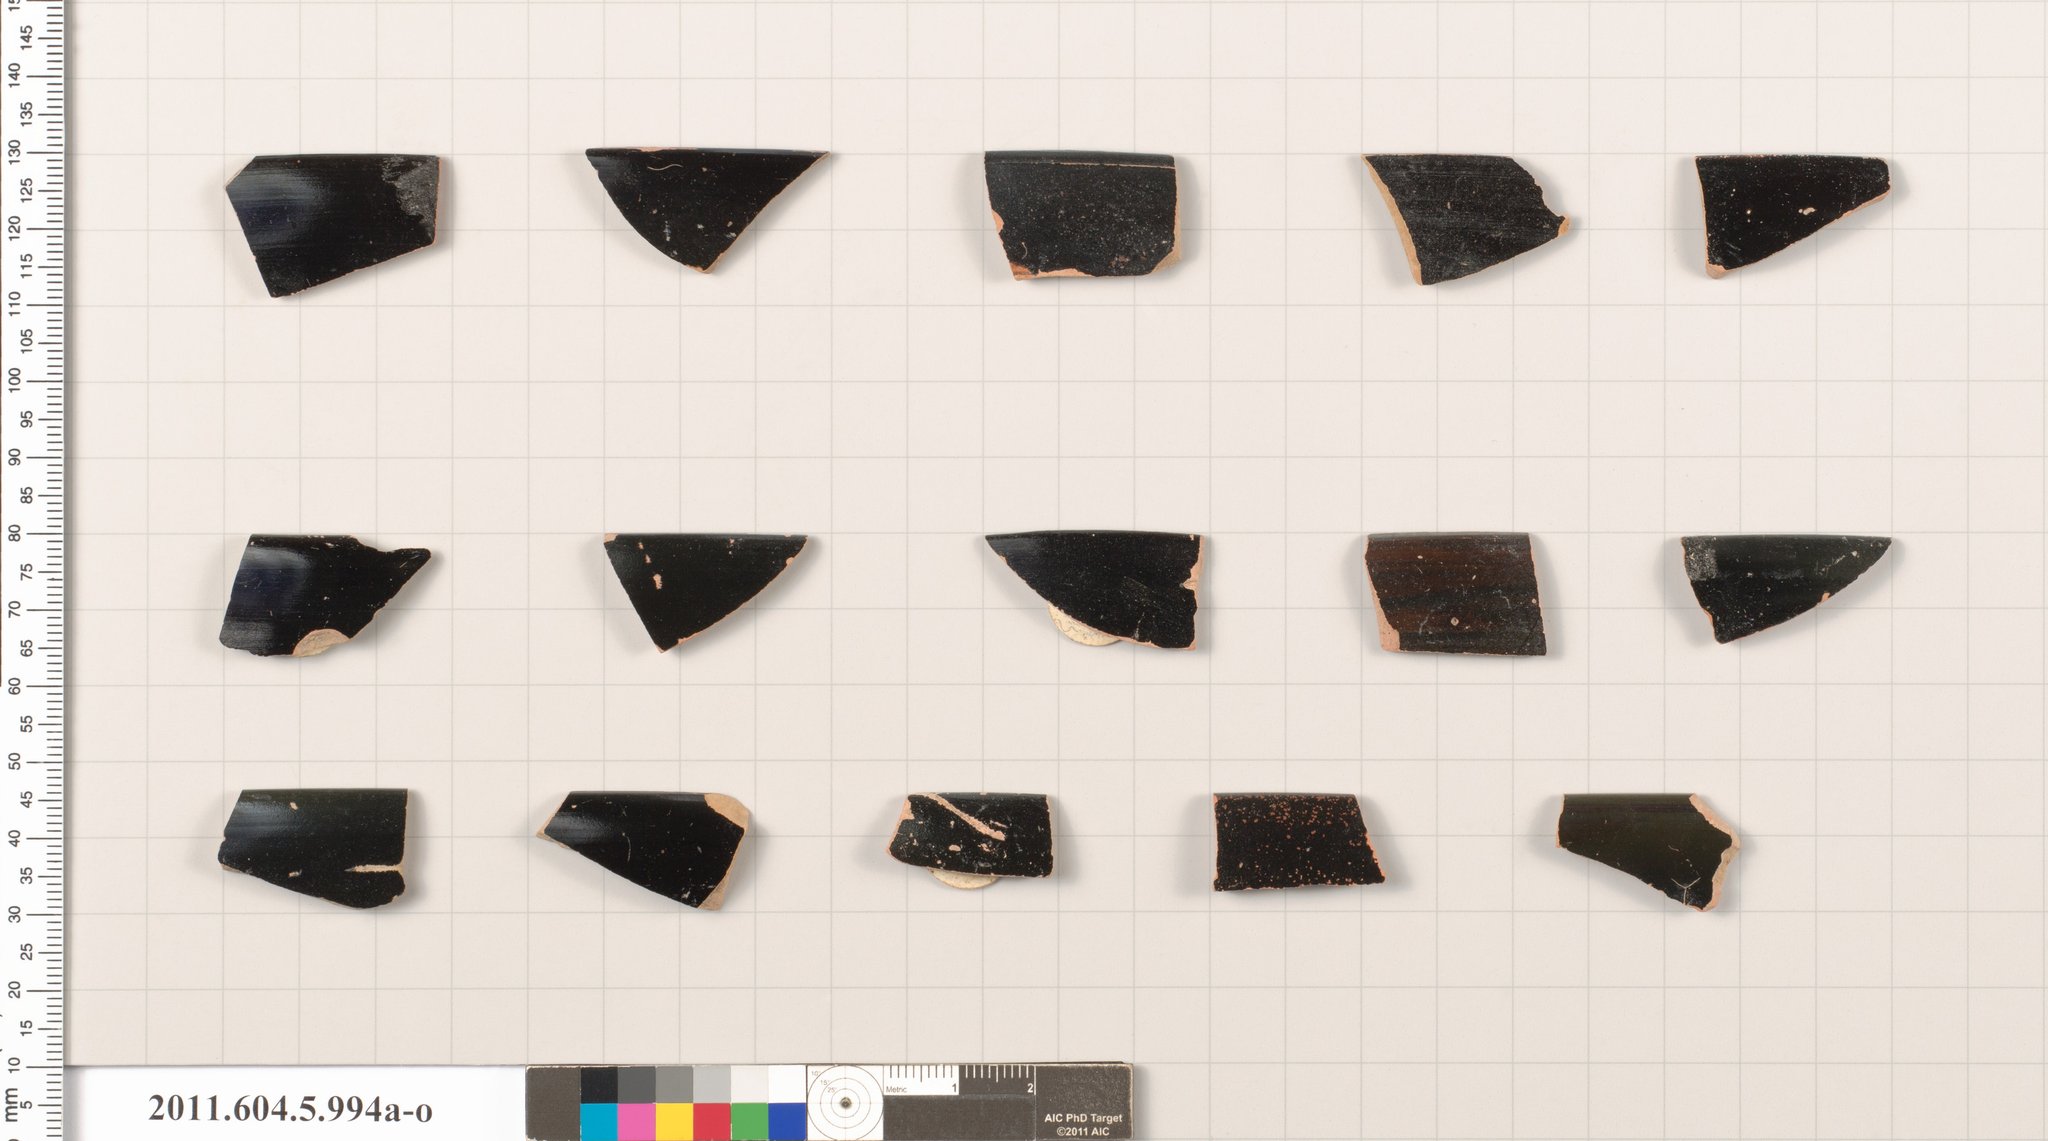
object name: kylix fragment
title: Terracotta rim fragments of kylikes (drinking cups)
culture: greek, attic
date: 600-401 BCE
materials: terracotta